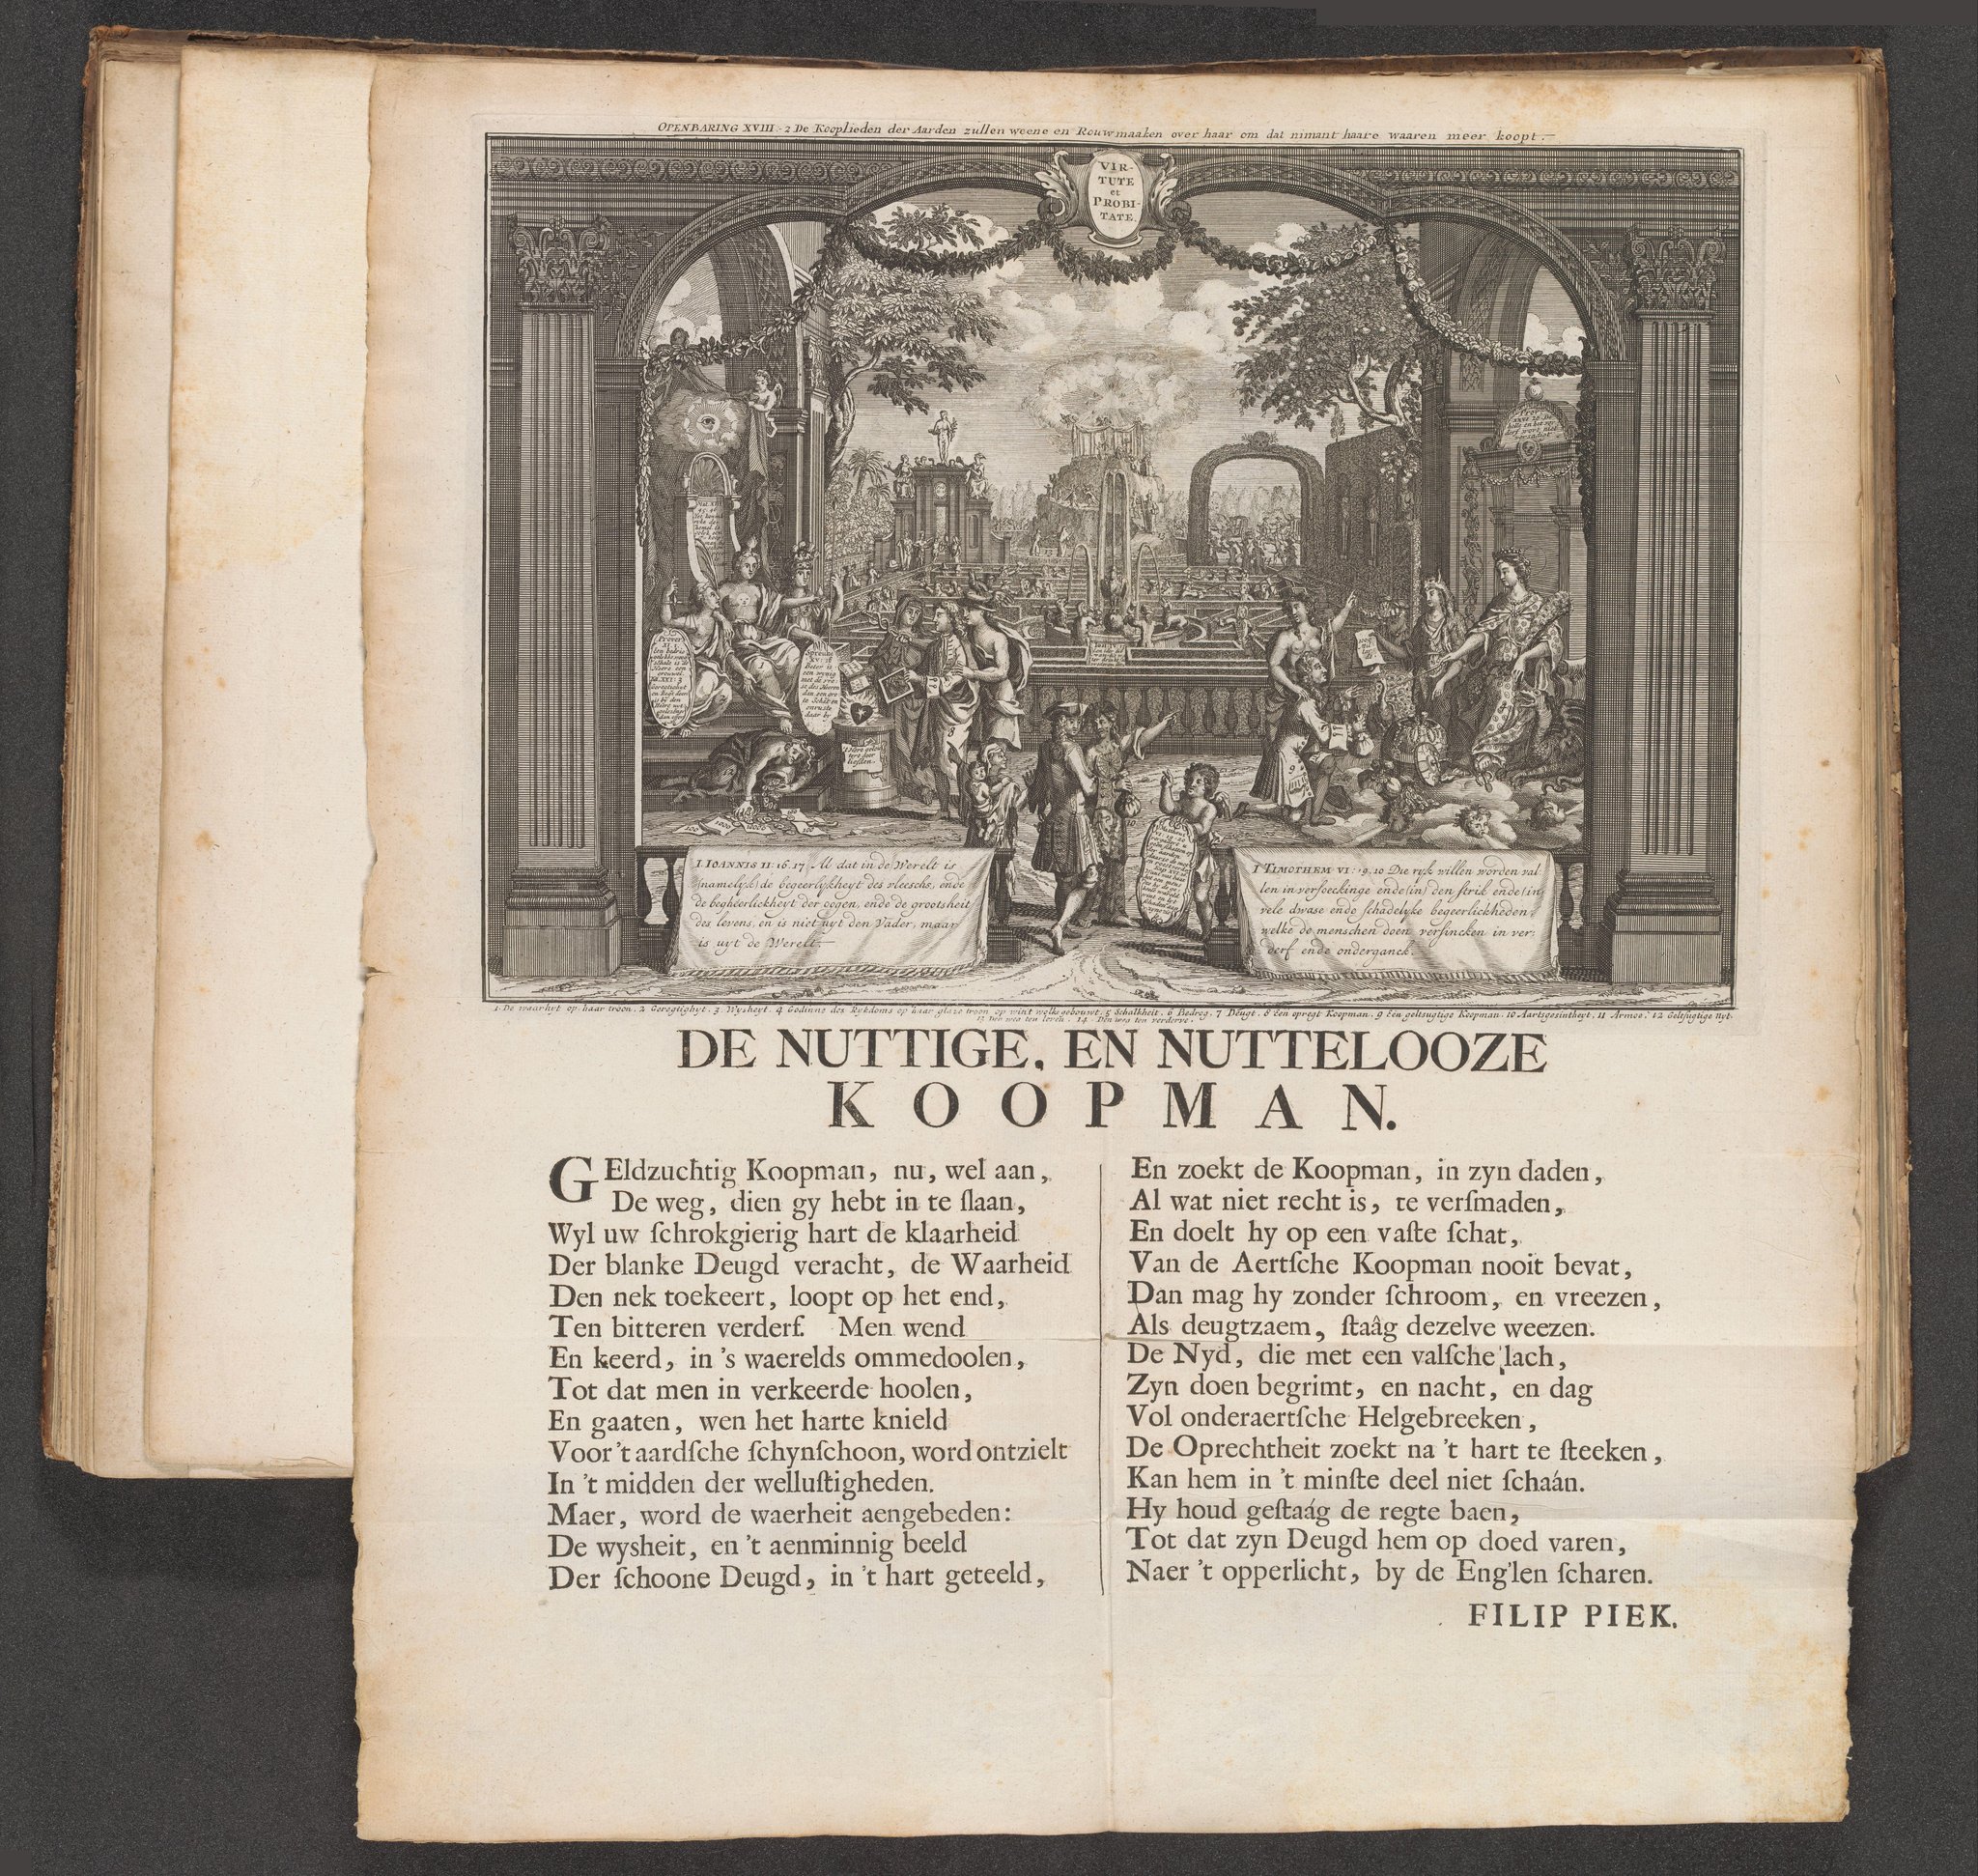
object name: cartoon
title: Het Groote Tafereel der Dwaasheid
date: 1720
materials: paper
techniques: engraving, etching, letterpress printing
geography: northern netherlands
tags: labyrinth, maze ~ garden, the way to destruction is broad and the gate is wide; the way to life is narrow and the gate is straight ~ doctrine of christ on love, etc. (matthew 7:13-14; luke 13:24), merchant, salesman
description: De oprechte en de geldzuchtige koopman. Links de oprechte koopman met Mercurius en Deugd voor de troon van de Waarheid, rechts de geldzuchtige koopman (de windhandelaar) met Bedrog en Schalkheid voor de troon van de Rijkdom. Op de balustrade bijbelcitaten. Op de achtergrond een tuin met een doolhof met de smalle en de brede weg. In het onderschrift de legenda 1-14 in het Nederlands. Apart gedrukt op het blad onder de plaat de titel en een vers van 2 kolommen. Prent in de gebonden vierde uitgave (304 B 12) van Het Groote Tafereel der Dwaasheid met spotprenten op de Windhandel of Actiehandel van 1720.